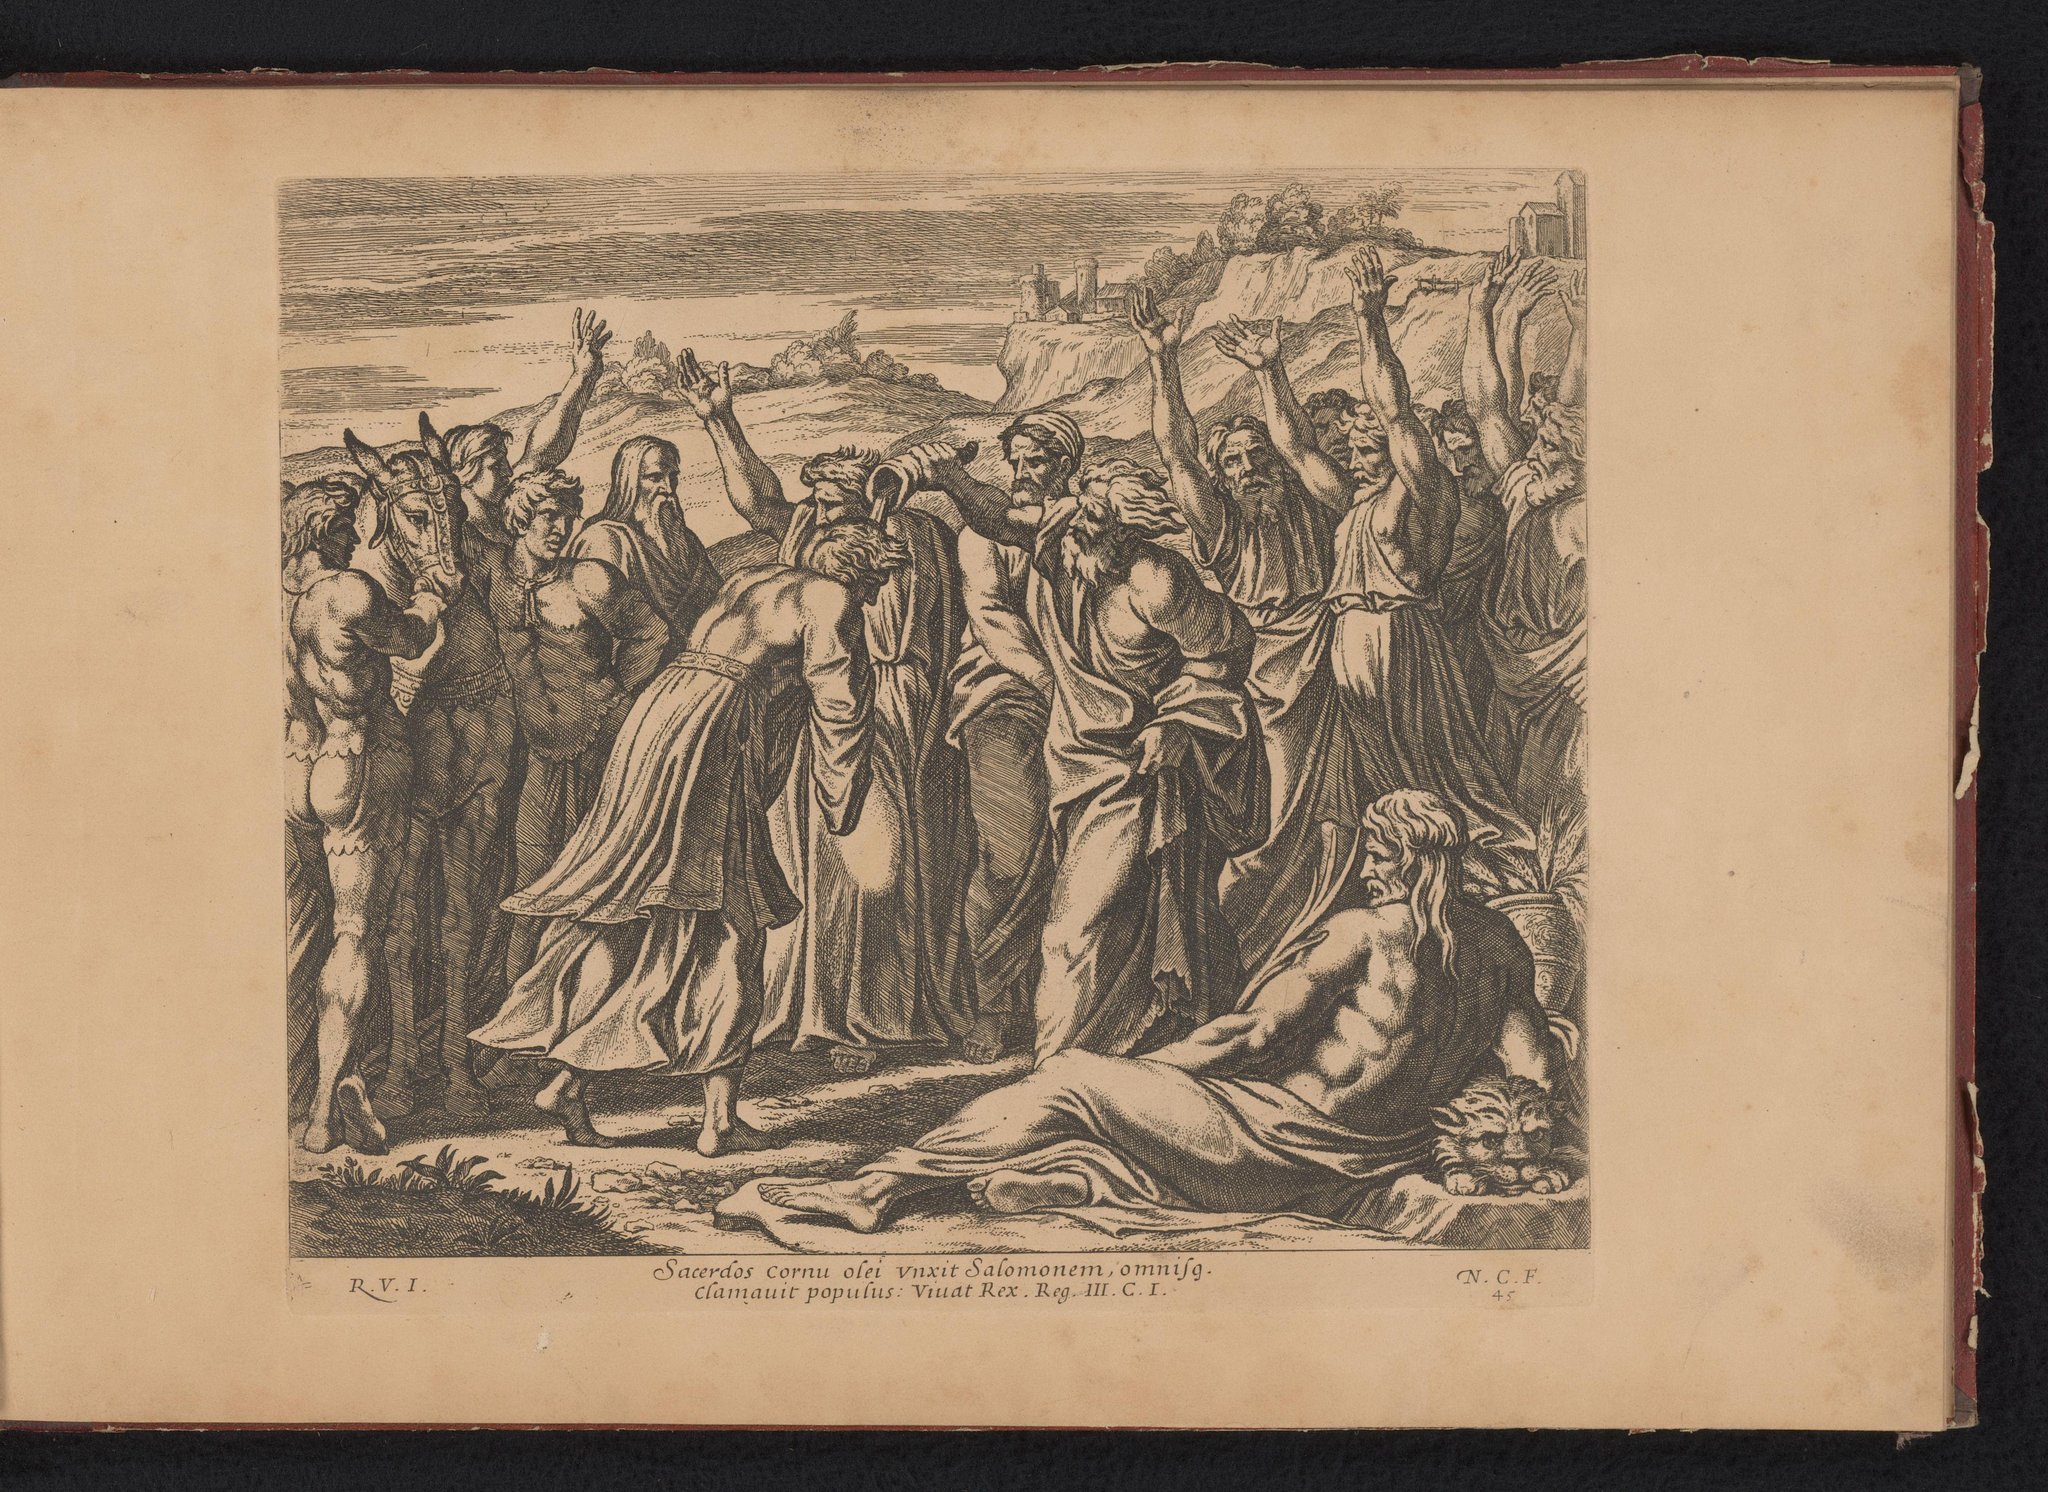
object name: album leaf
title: David bespiedt Batseba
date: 1649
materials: paper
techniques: etching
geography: paris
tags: david, from the roof (or balcony) of his palace, sees bathsheba bathing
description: Deze prent maakt deel uit van een album.